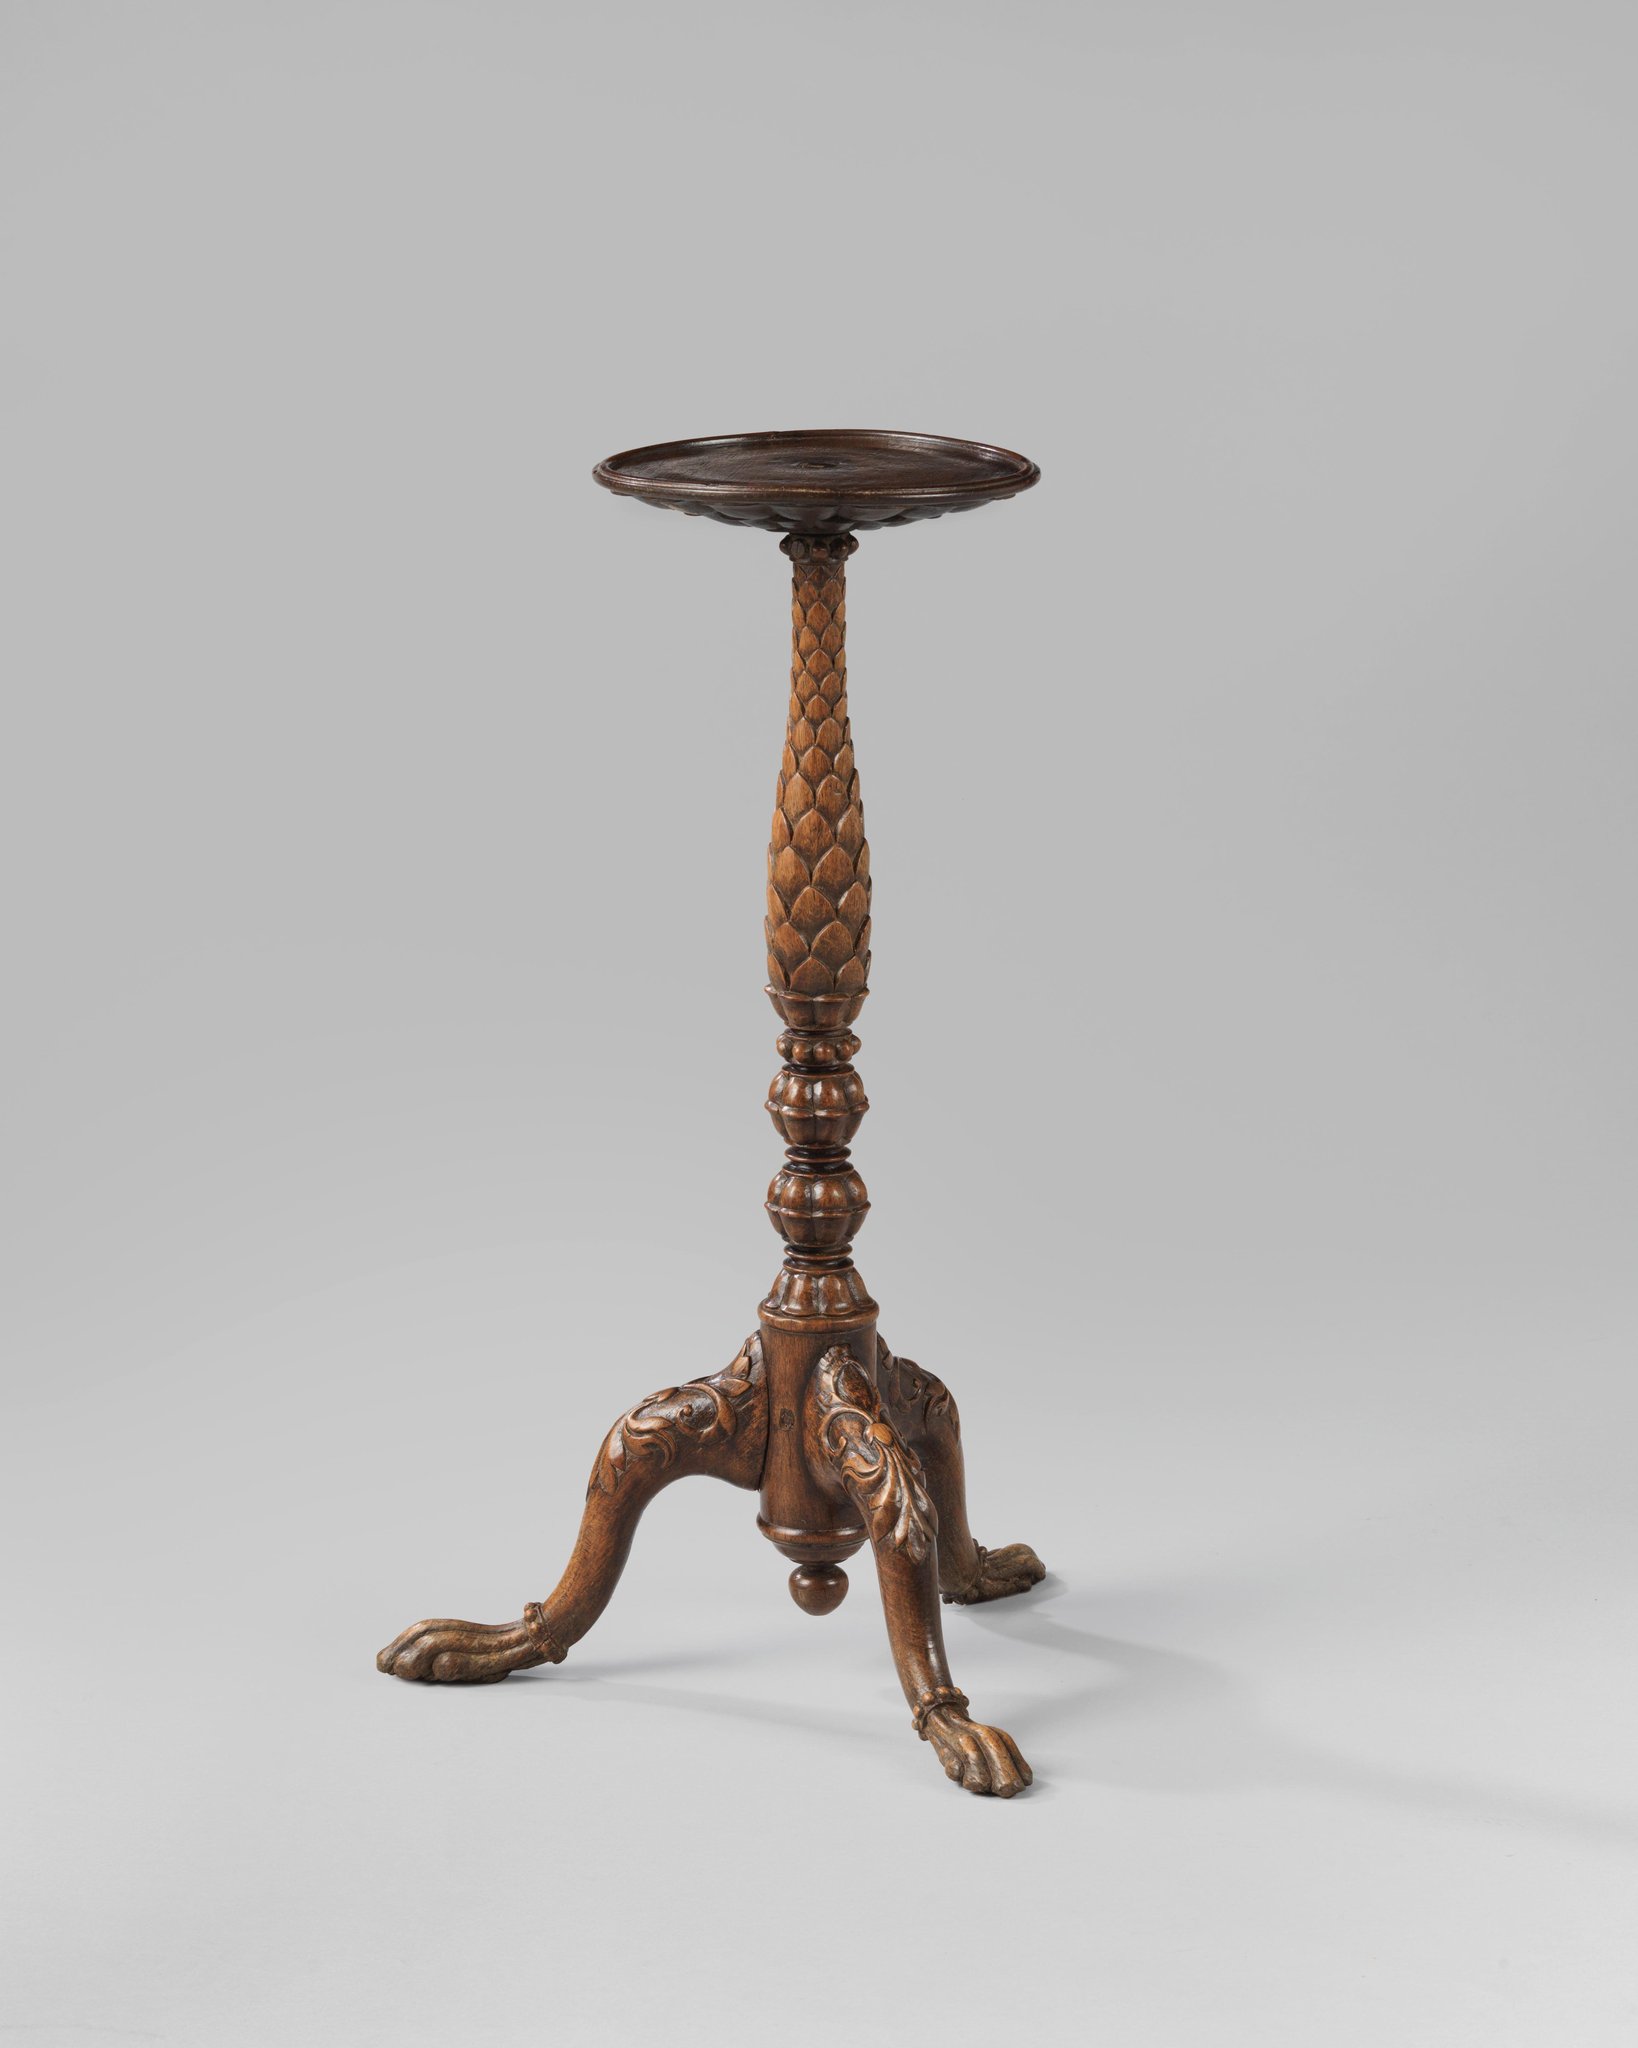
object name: table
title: Gueridon op balustervormige stam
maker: Anonymous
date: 1700-1800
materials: wood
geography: indonesia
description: Gueridon. Teak. Indonesia, 1700 - 1750. A gueridon is a small tall table, originally designed to hold a candelabrum.